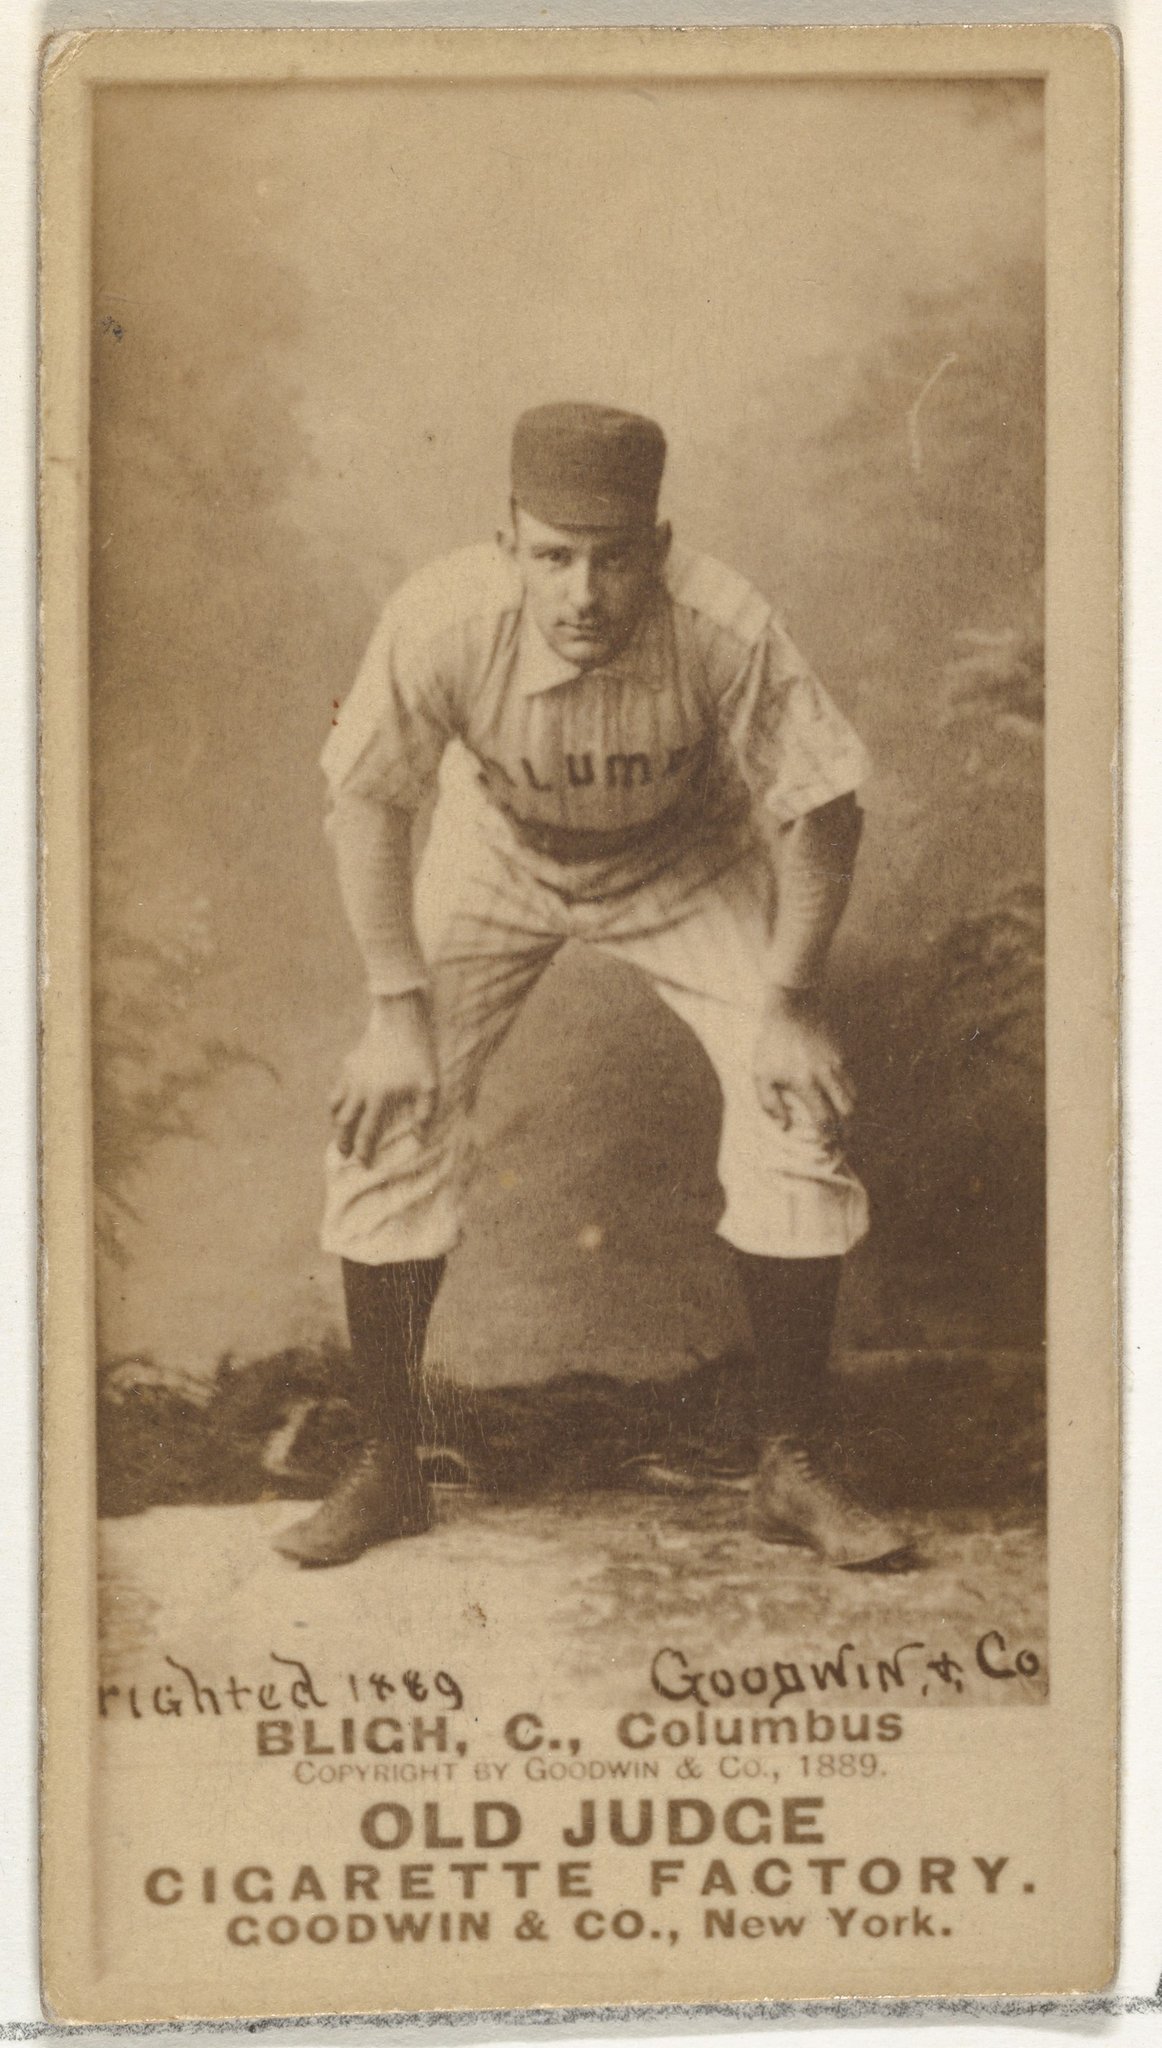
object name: baseball card, photograph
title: Edwin Forrest "Ned" Bligh, Catcher, Cleveland, from the Old Judge series (N172) for Old Judge Cigarettes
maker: goodwin & company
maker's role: publisher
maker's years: 1850-1950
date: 1889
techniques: albumen silver print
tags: men,portraits,baseball,athletes